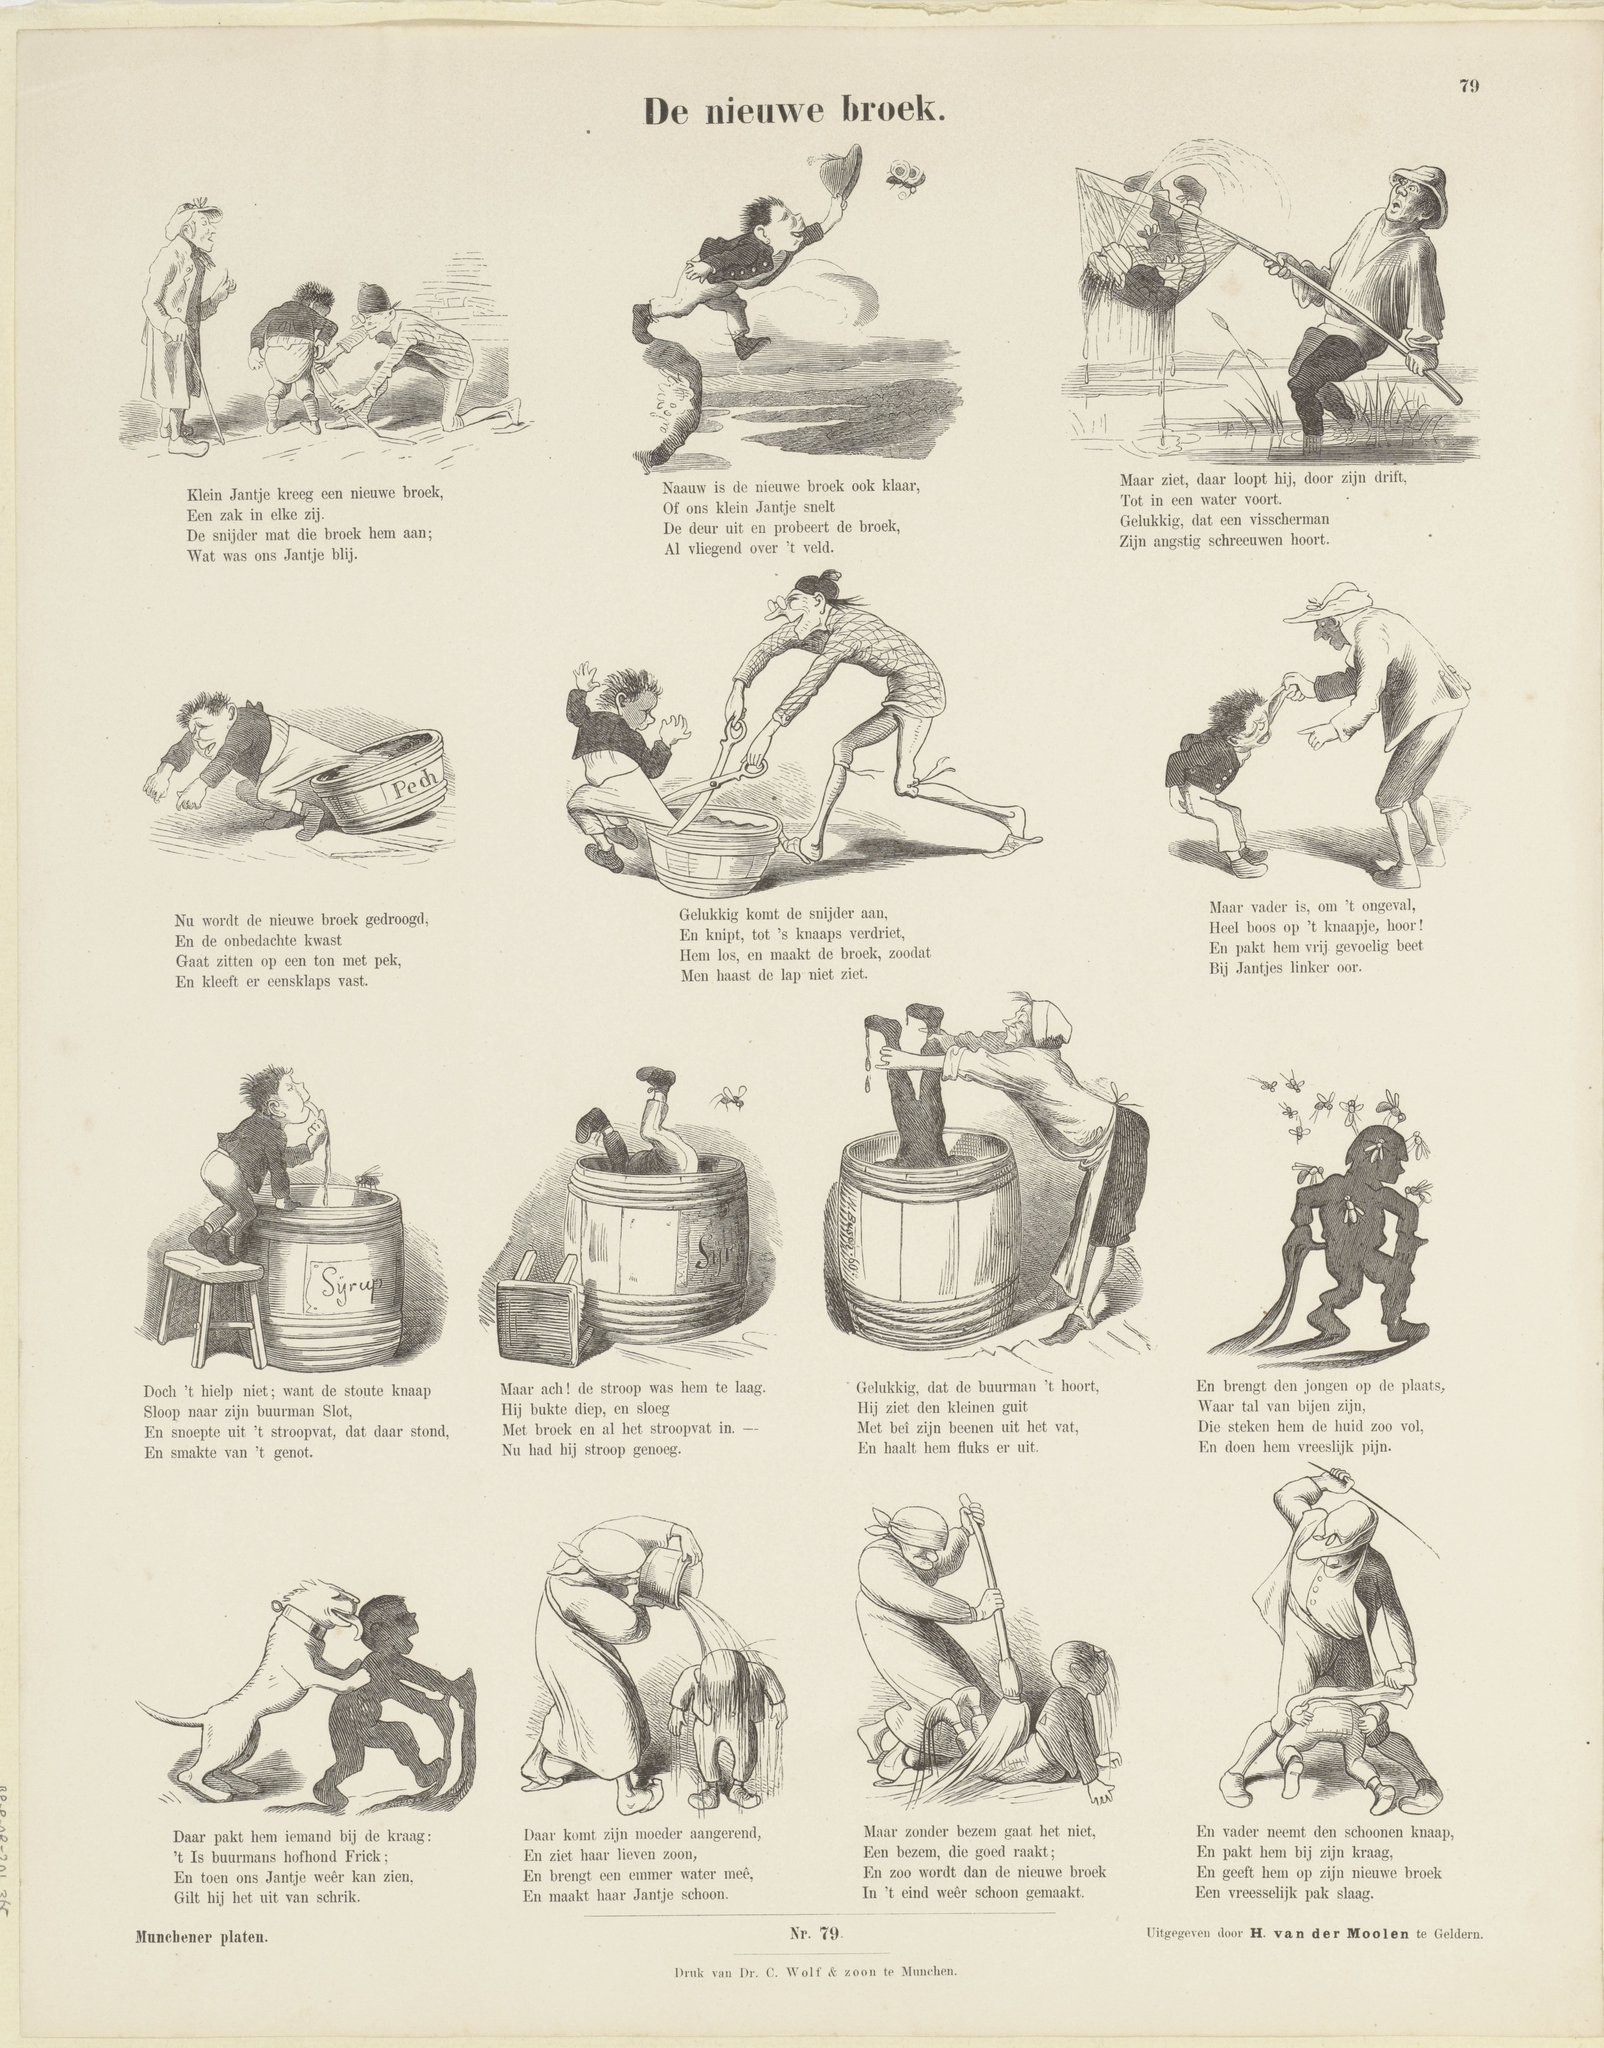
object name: popular print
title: De nieuwe broek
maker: hermann van der moolen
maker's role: publisher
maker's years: 1828-1892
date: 1860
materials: paper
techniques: letterpress printing, engraving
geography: geldern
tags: mischief-making play, correction of naughty children, trousers, breeches, etc. (trousers) (+ men's clothes), bad behaviour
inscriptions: collector's mark: Lugt 2760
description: Blad met 14 voorstellingen over Jantje die met zijn nieuwe broek allerlei kattenkwaad uithaalt en een pak slaag krijgt. Onder elke afbeelding een vierregelig vers. Genummerd midden onder: Nro. 79. Genummerd rechtsboven: 79.